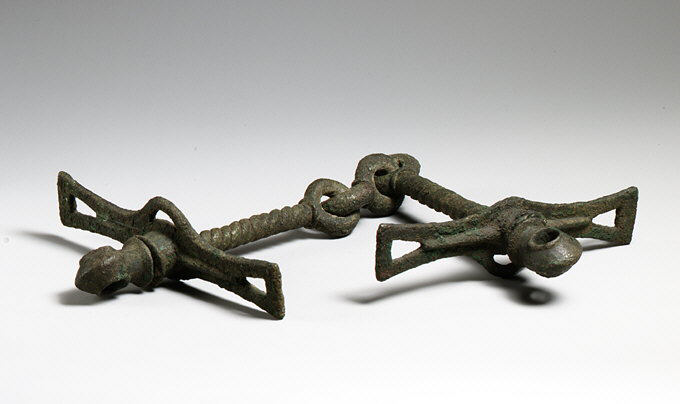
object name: horse bit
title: Bronze bit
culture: cypriot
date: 600 BCE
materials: bronze